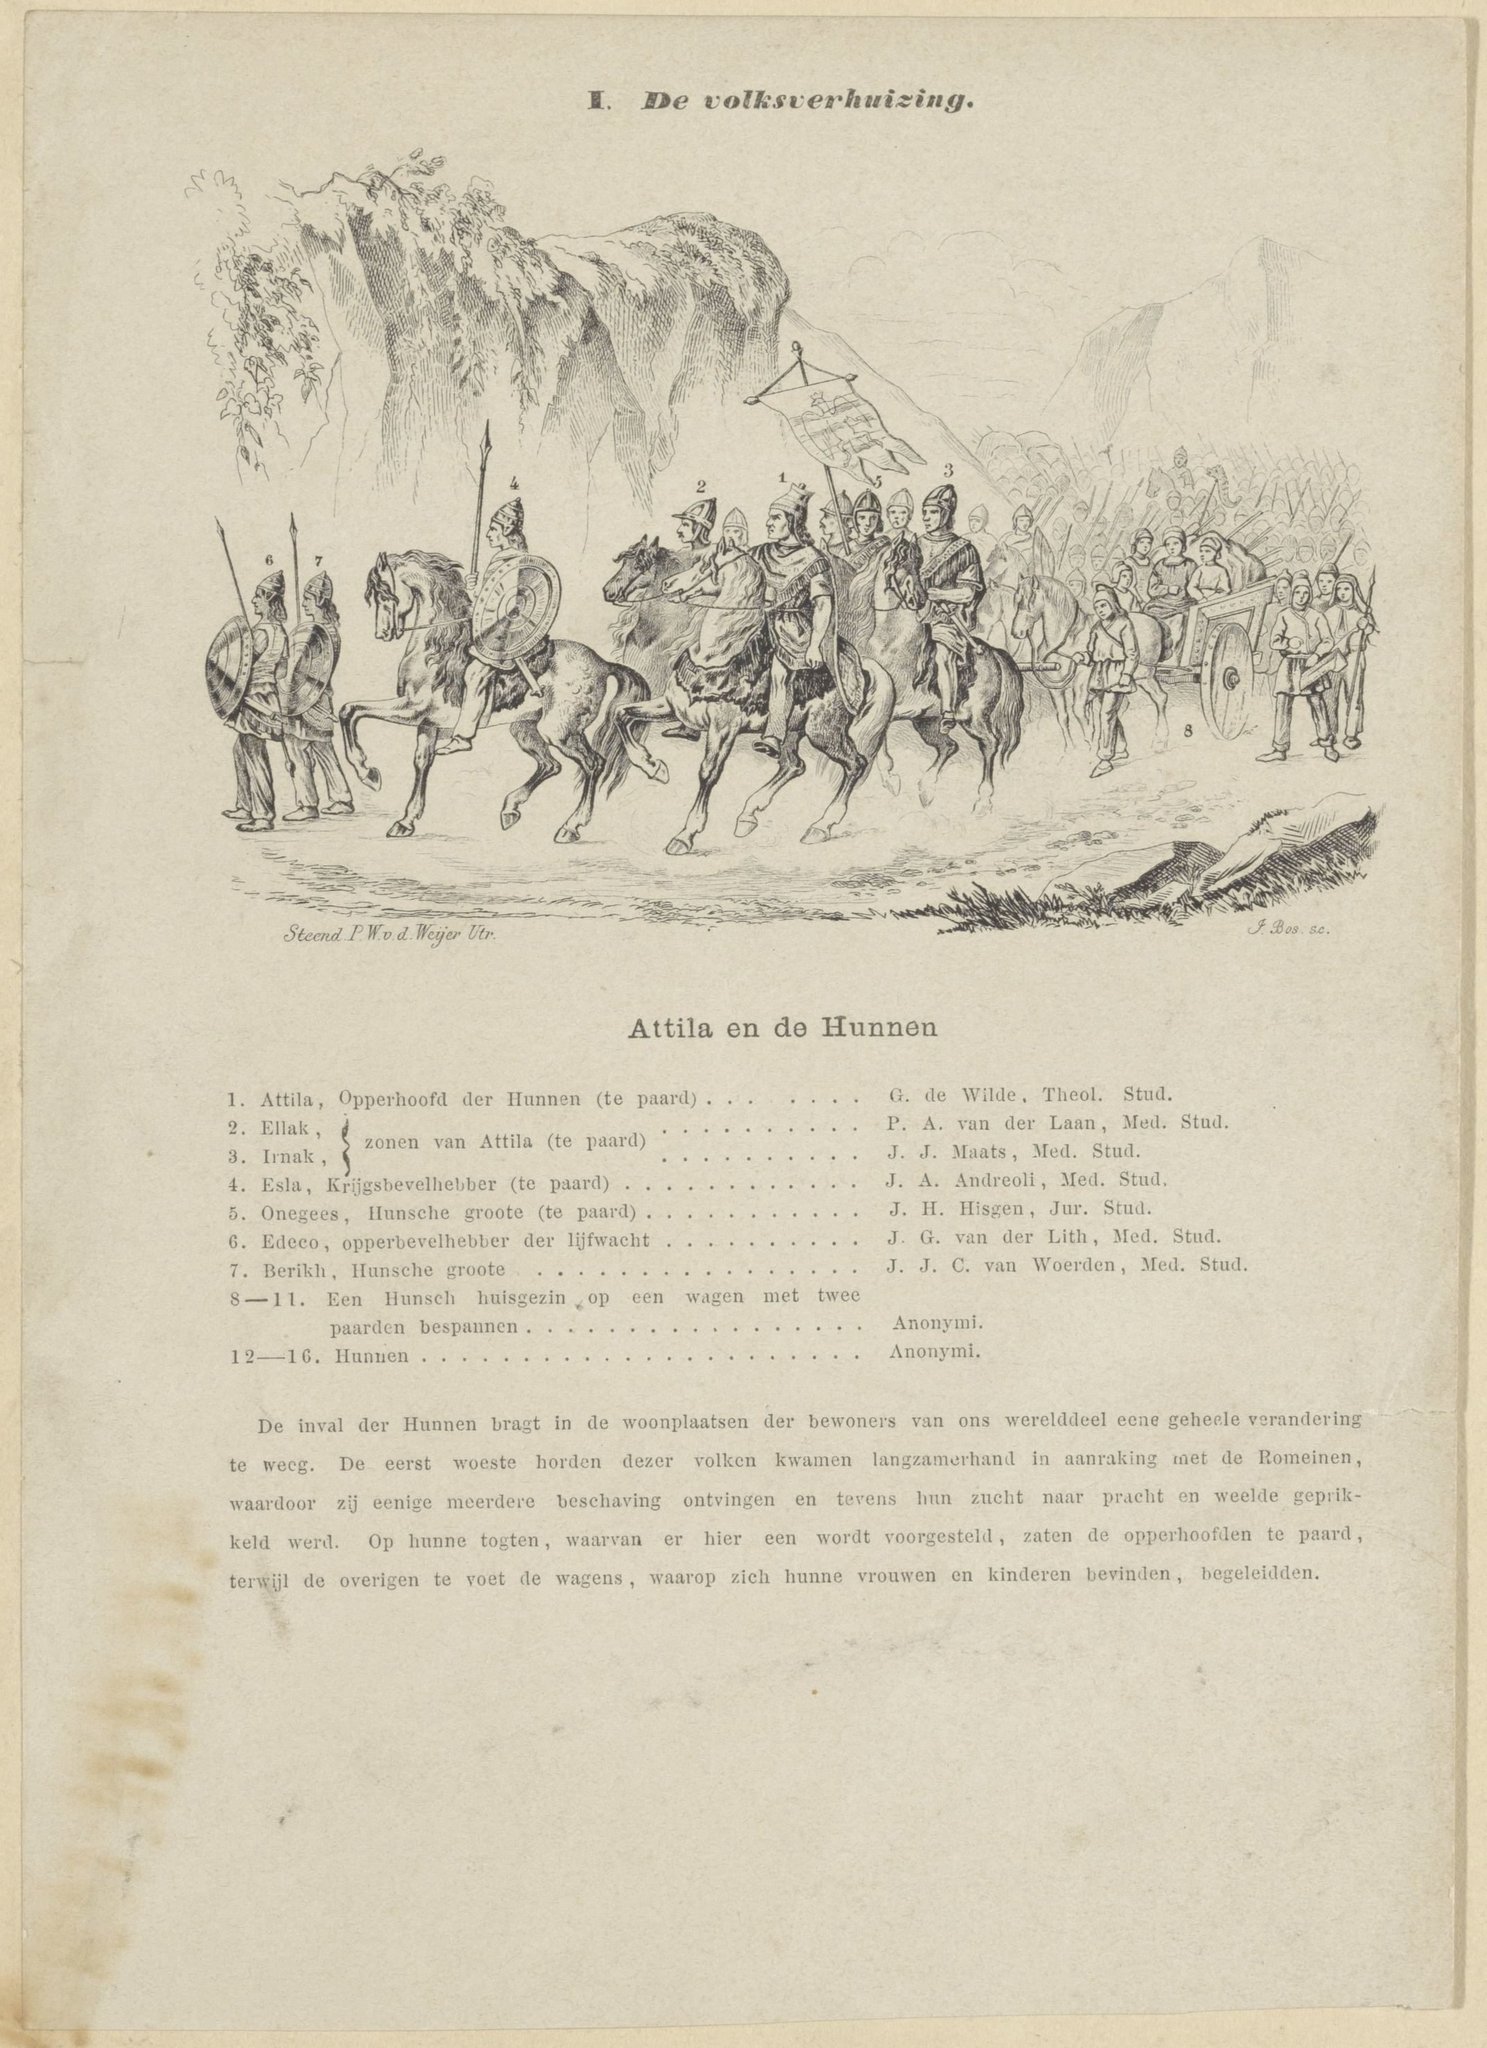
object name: print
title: Programma maskerade studenten Attila en de Hunnen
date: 1861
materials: paper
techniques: lithograph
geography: netherlands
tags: troop movements, transportation, wandering communities: nomads, utrecht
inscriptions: collector's mark: Lugt 2228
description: Een leger van Hunnen komt door een bergpas. Voorop lopen twee Hunnen met speren en schilden. Daarachter een groep ruiters met een vaandel, waaronder Atilla de Hun. Daarachter de rest van het leger te voet en met paard en wagen. Bij de figuren staan nummers. Onder te afbeelding staan de nummers met daarbij de rol en de naam van de uitvoerende student. Daaronder een tekst over de Hunnnen en een beschrijving van de scène.